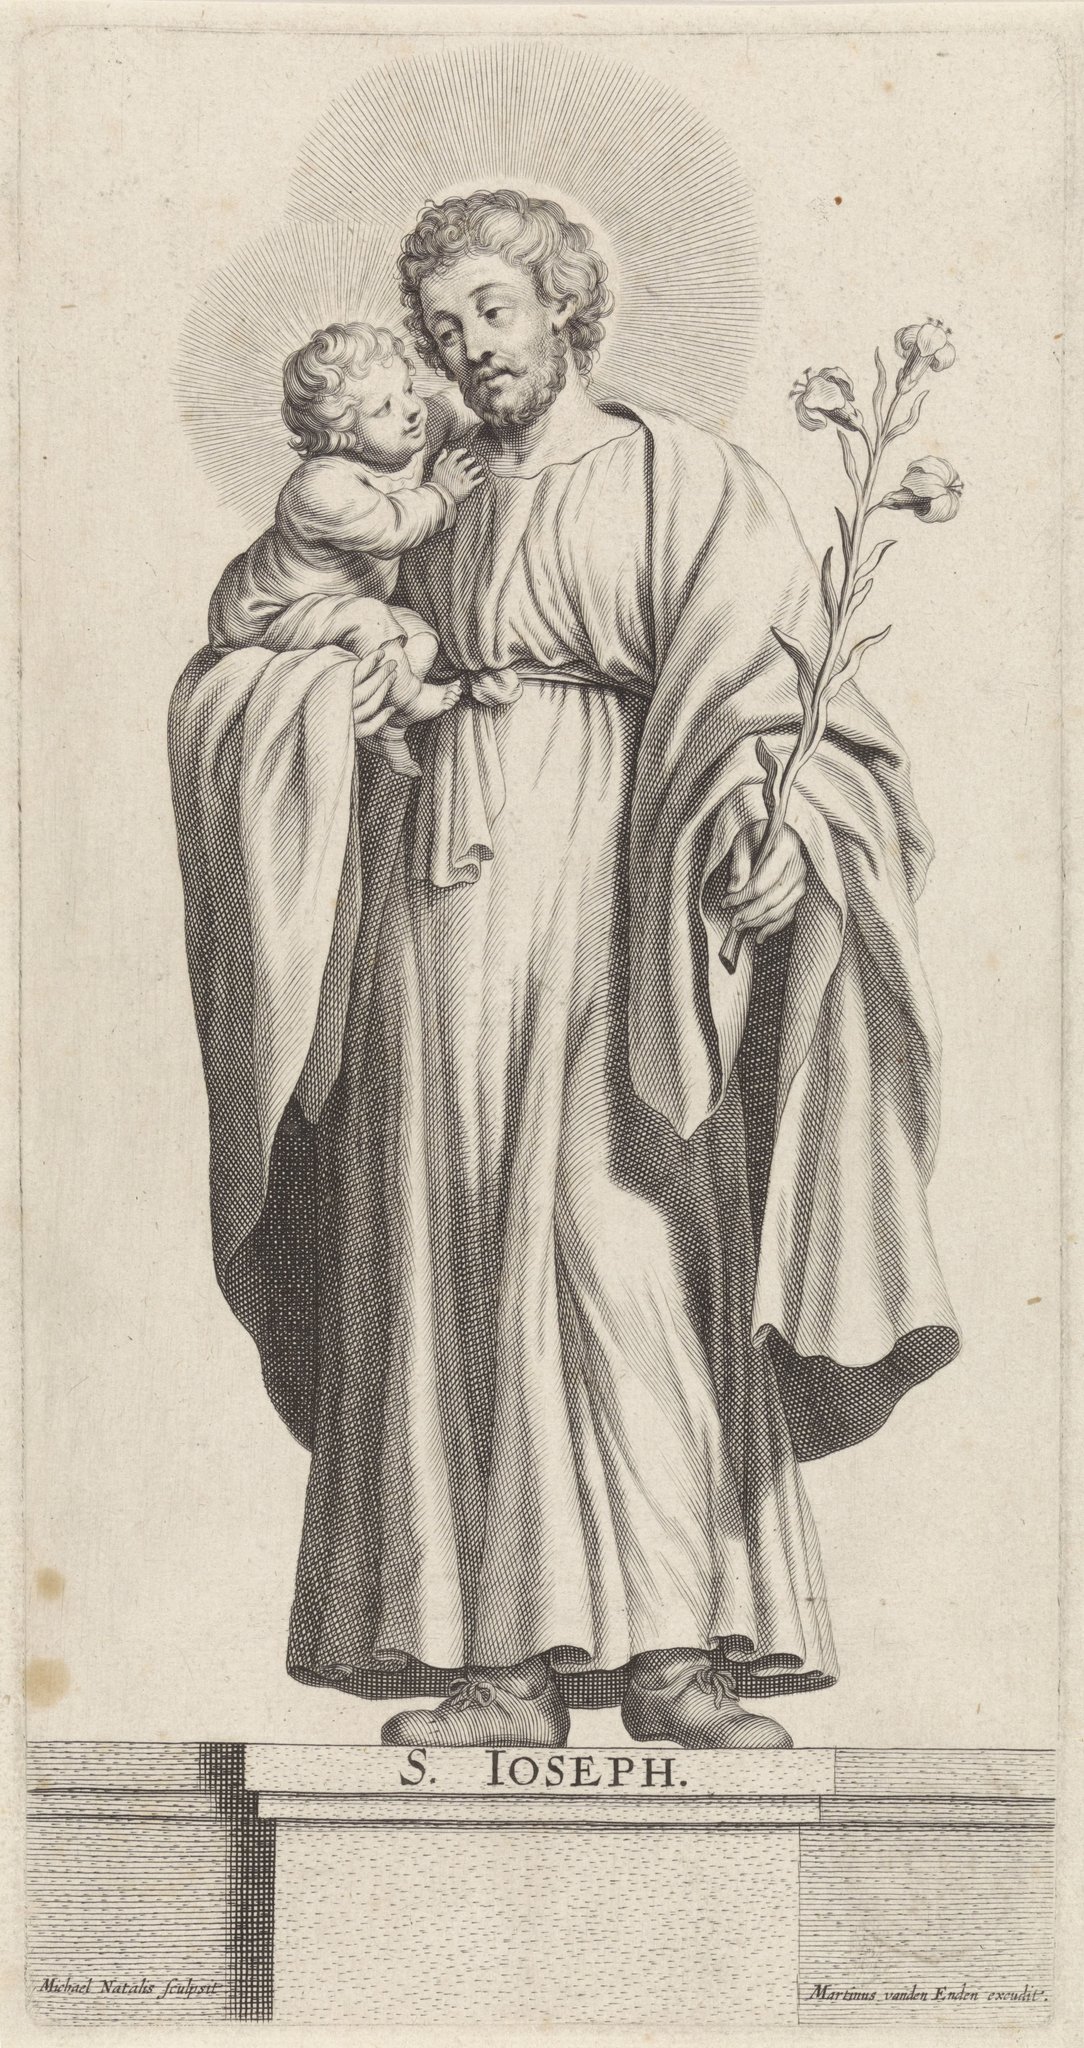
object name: print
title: De heilige Jozef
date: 1620-1668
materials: paper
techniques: engraving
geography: antwerp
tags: the foster-father of christ, joseph of nazareth, husband of mary; possible attributes: flowering rod or wand, lily, carpenter's tools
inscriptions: collector's mark: Lugt 240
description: De heilige Jozef met het Christuskind op de arm. In zijn andere hand draagt hij een lelie. Prent uit een serie van heiligen.